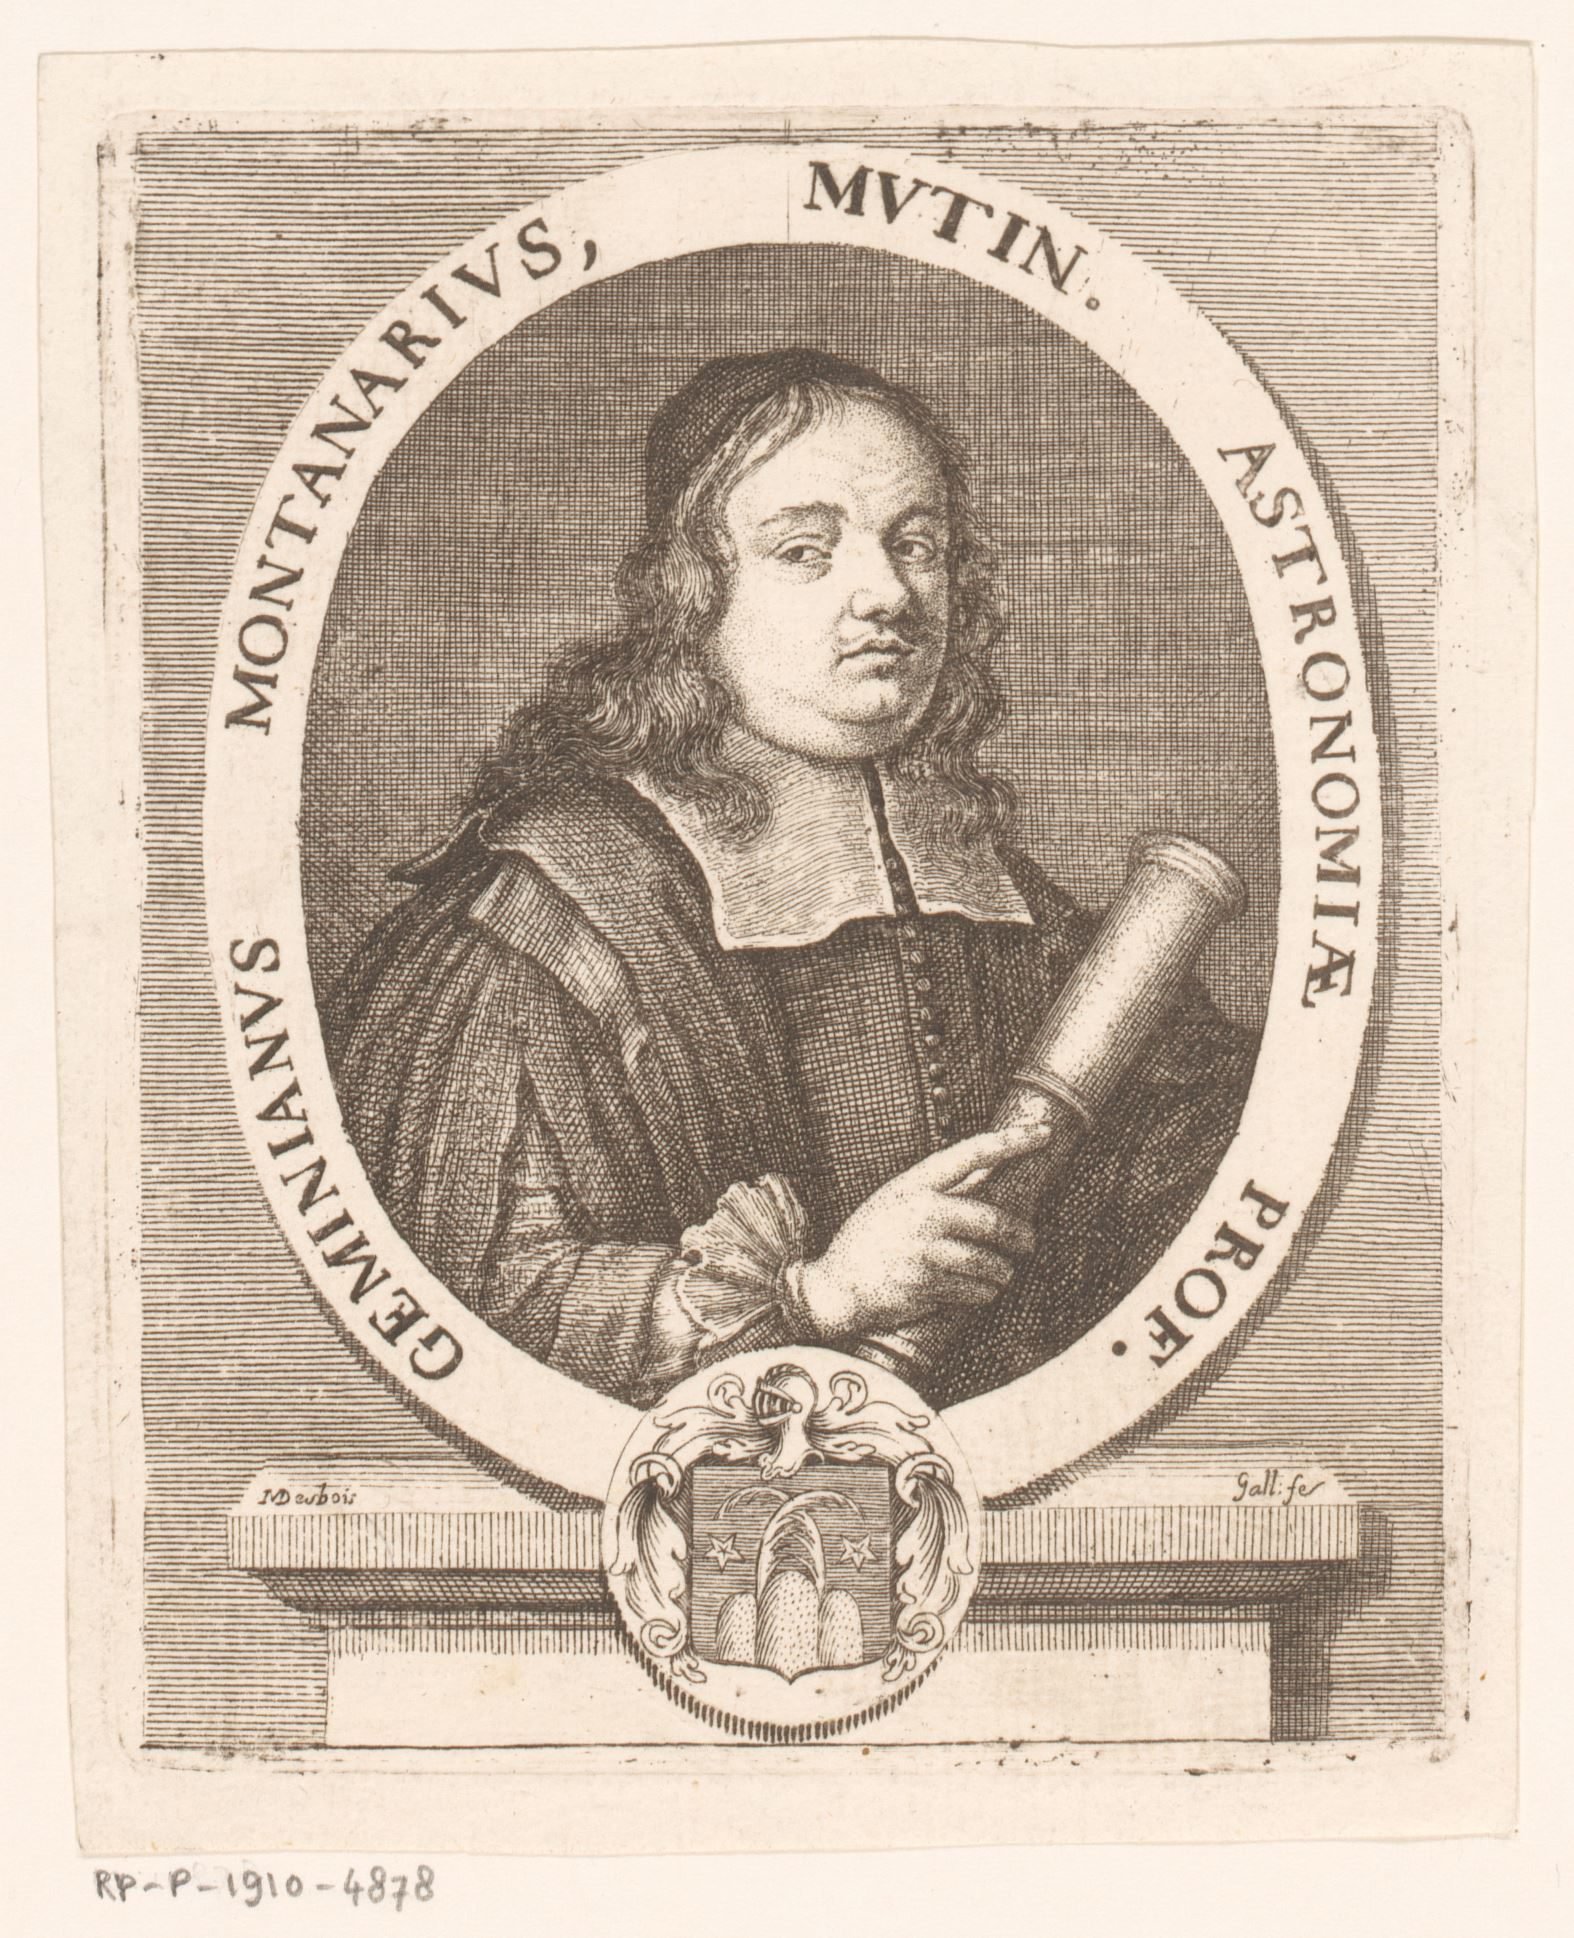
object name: book illustration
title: Portret van Geminiano Montanari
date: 1682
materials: paper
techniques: engraving, etching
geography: padua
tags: historical persons, professor, armorial bearing, heraldry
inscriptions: collector's mark: Lugt 2228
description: Prent uit: Patin, Charles. Lyceum Patavinum: sive icones et vitae professorum. Padua: Frambotti, Petri Mariae, 1682.